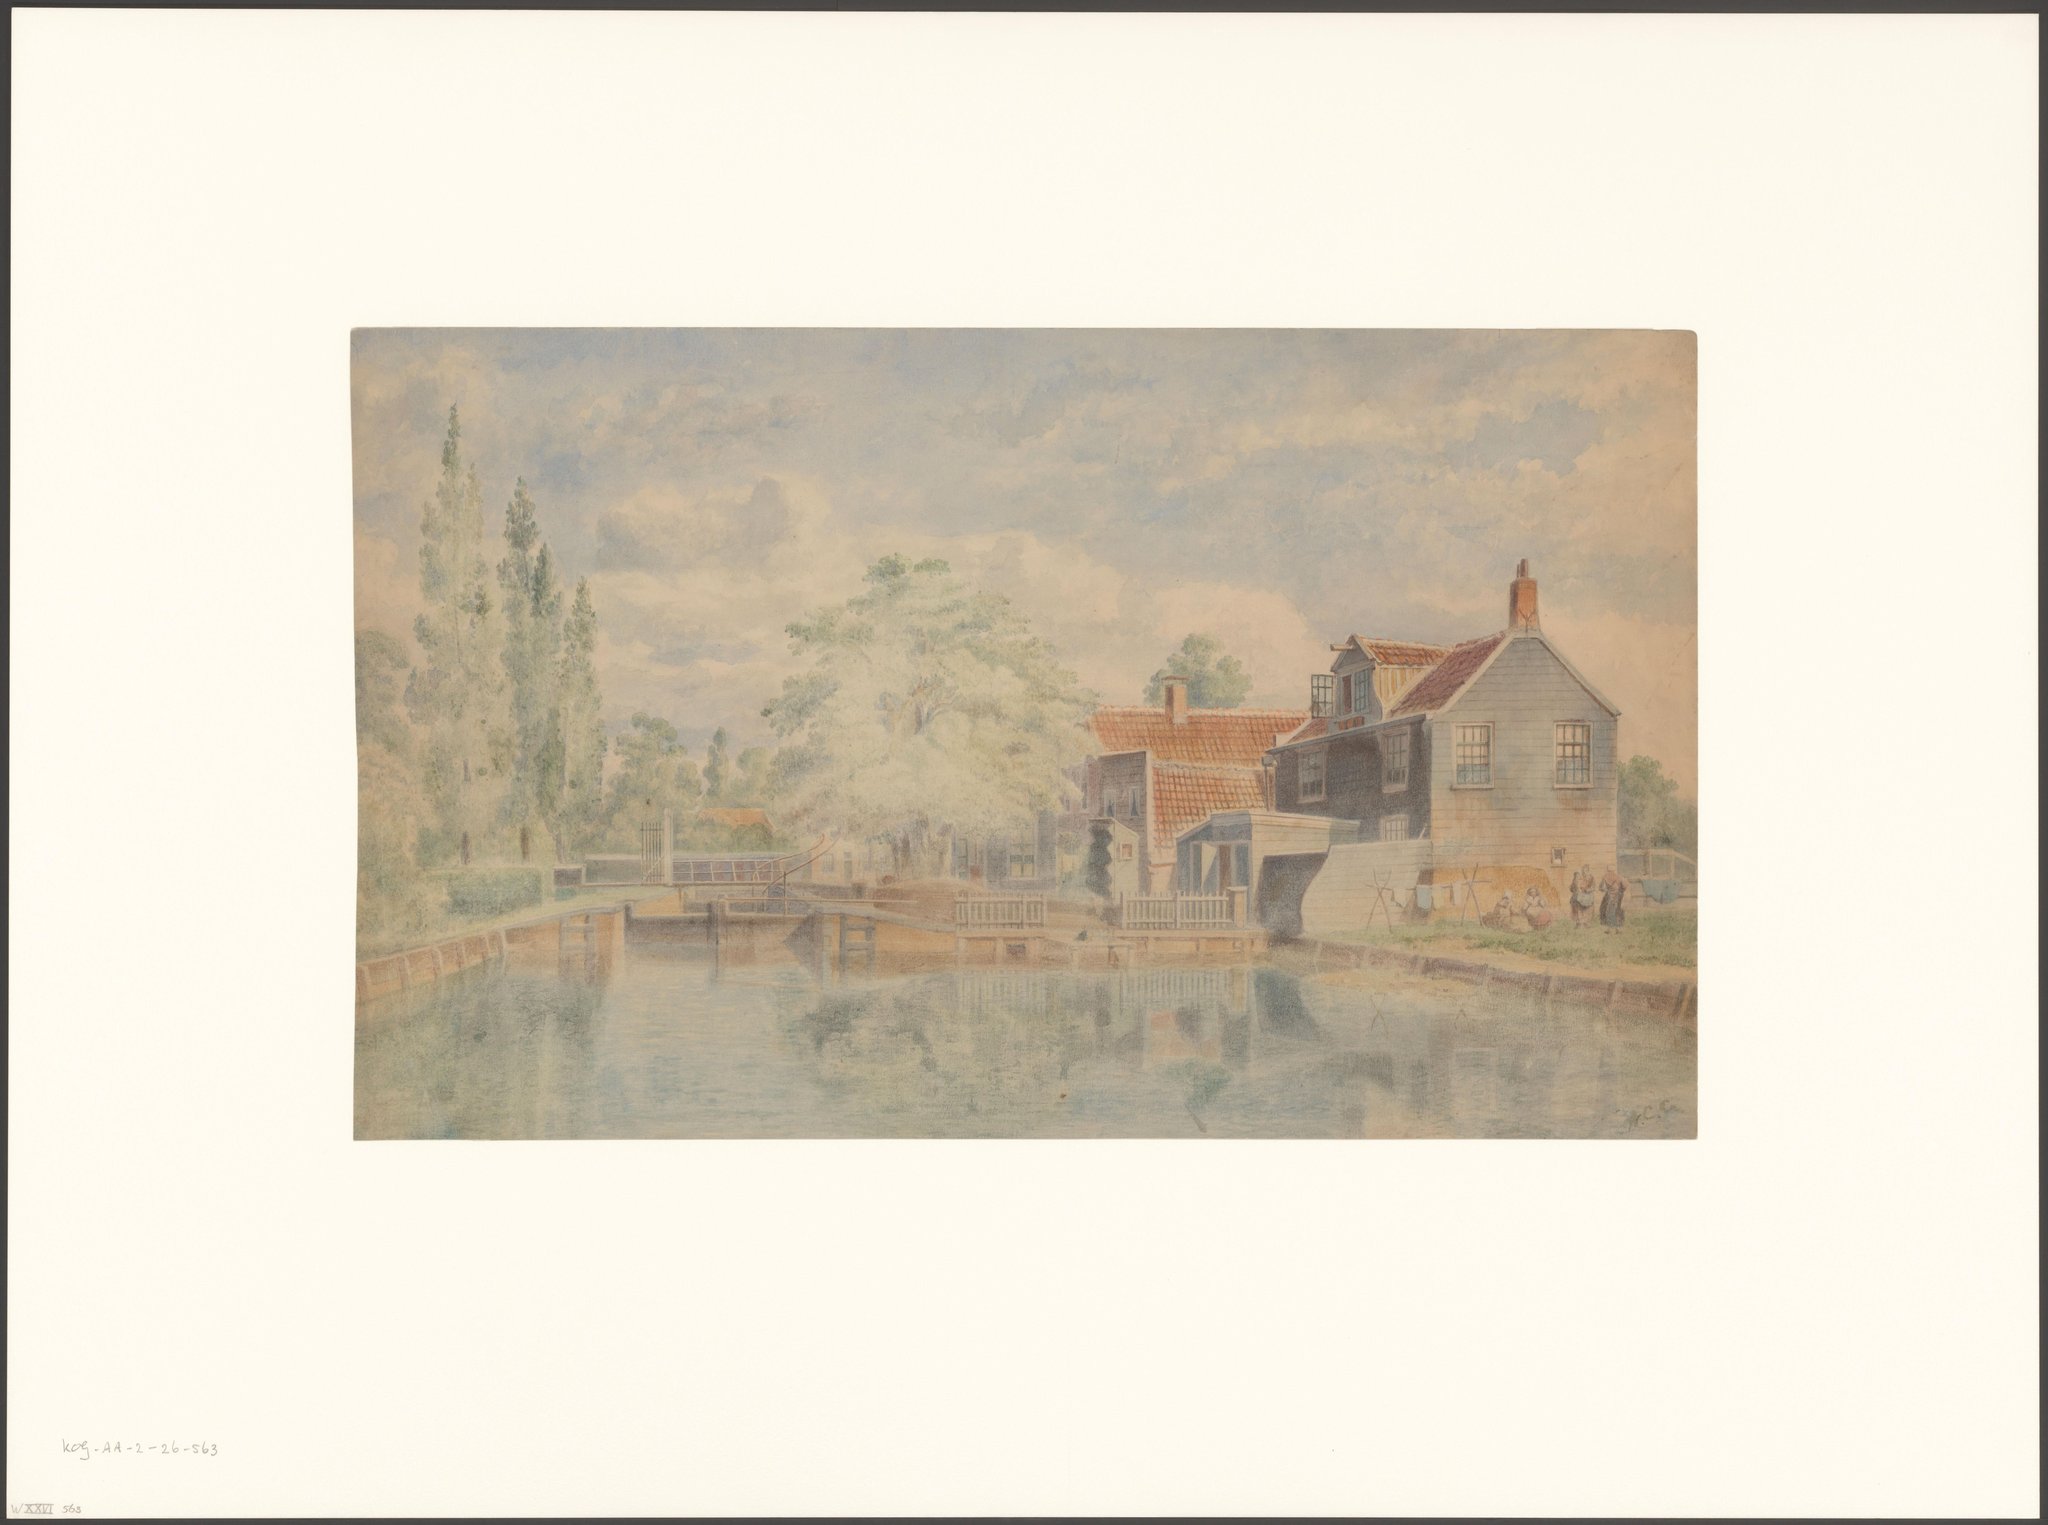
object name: drawing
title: Gezicht op huizen langs een kanaal in omgeving Amsterdam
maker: Anonymous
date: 1825-1925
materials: chalk, paper, watercolor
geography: amsterdam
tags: city-view in general; 'veduta', canal, the usual house or row of houses, amsterdam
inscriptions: signature: ‘A.C.G.’, collector's mark: Lugt 800a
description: Tekening binnen de Atlas Van Eck ingedeeld op wijknummer 26.